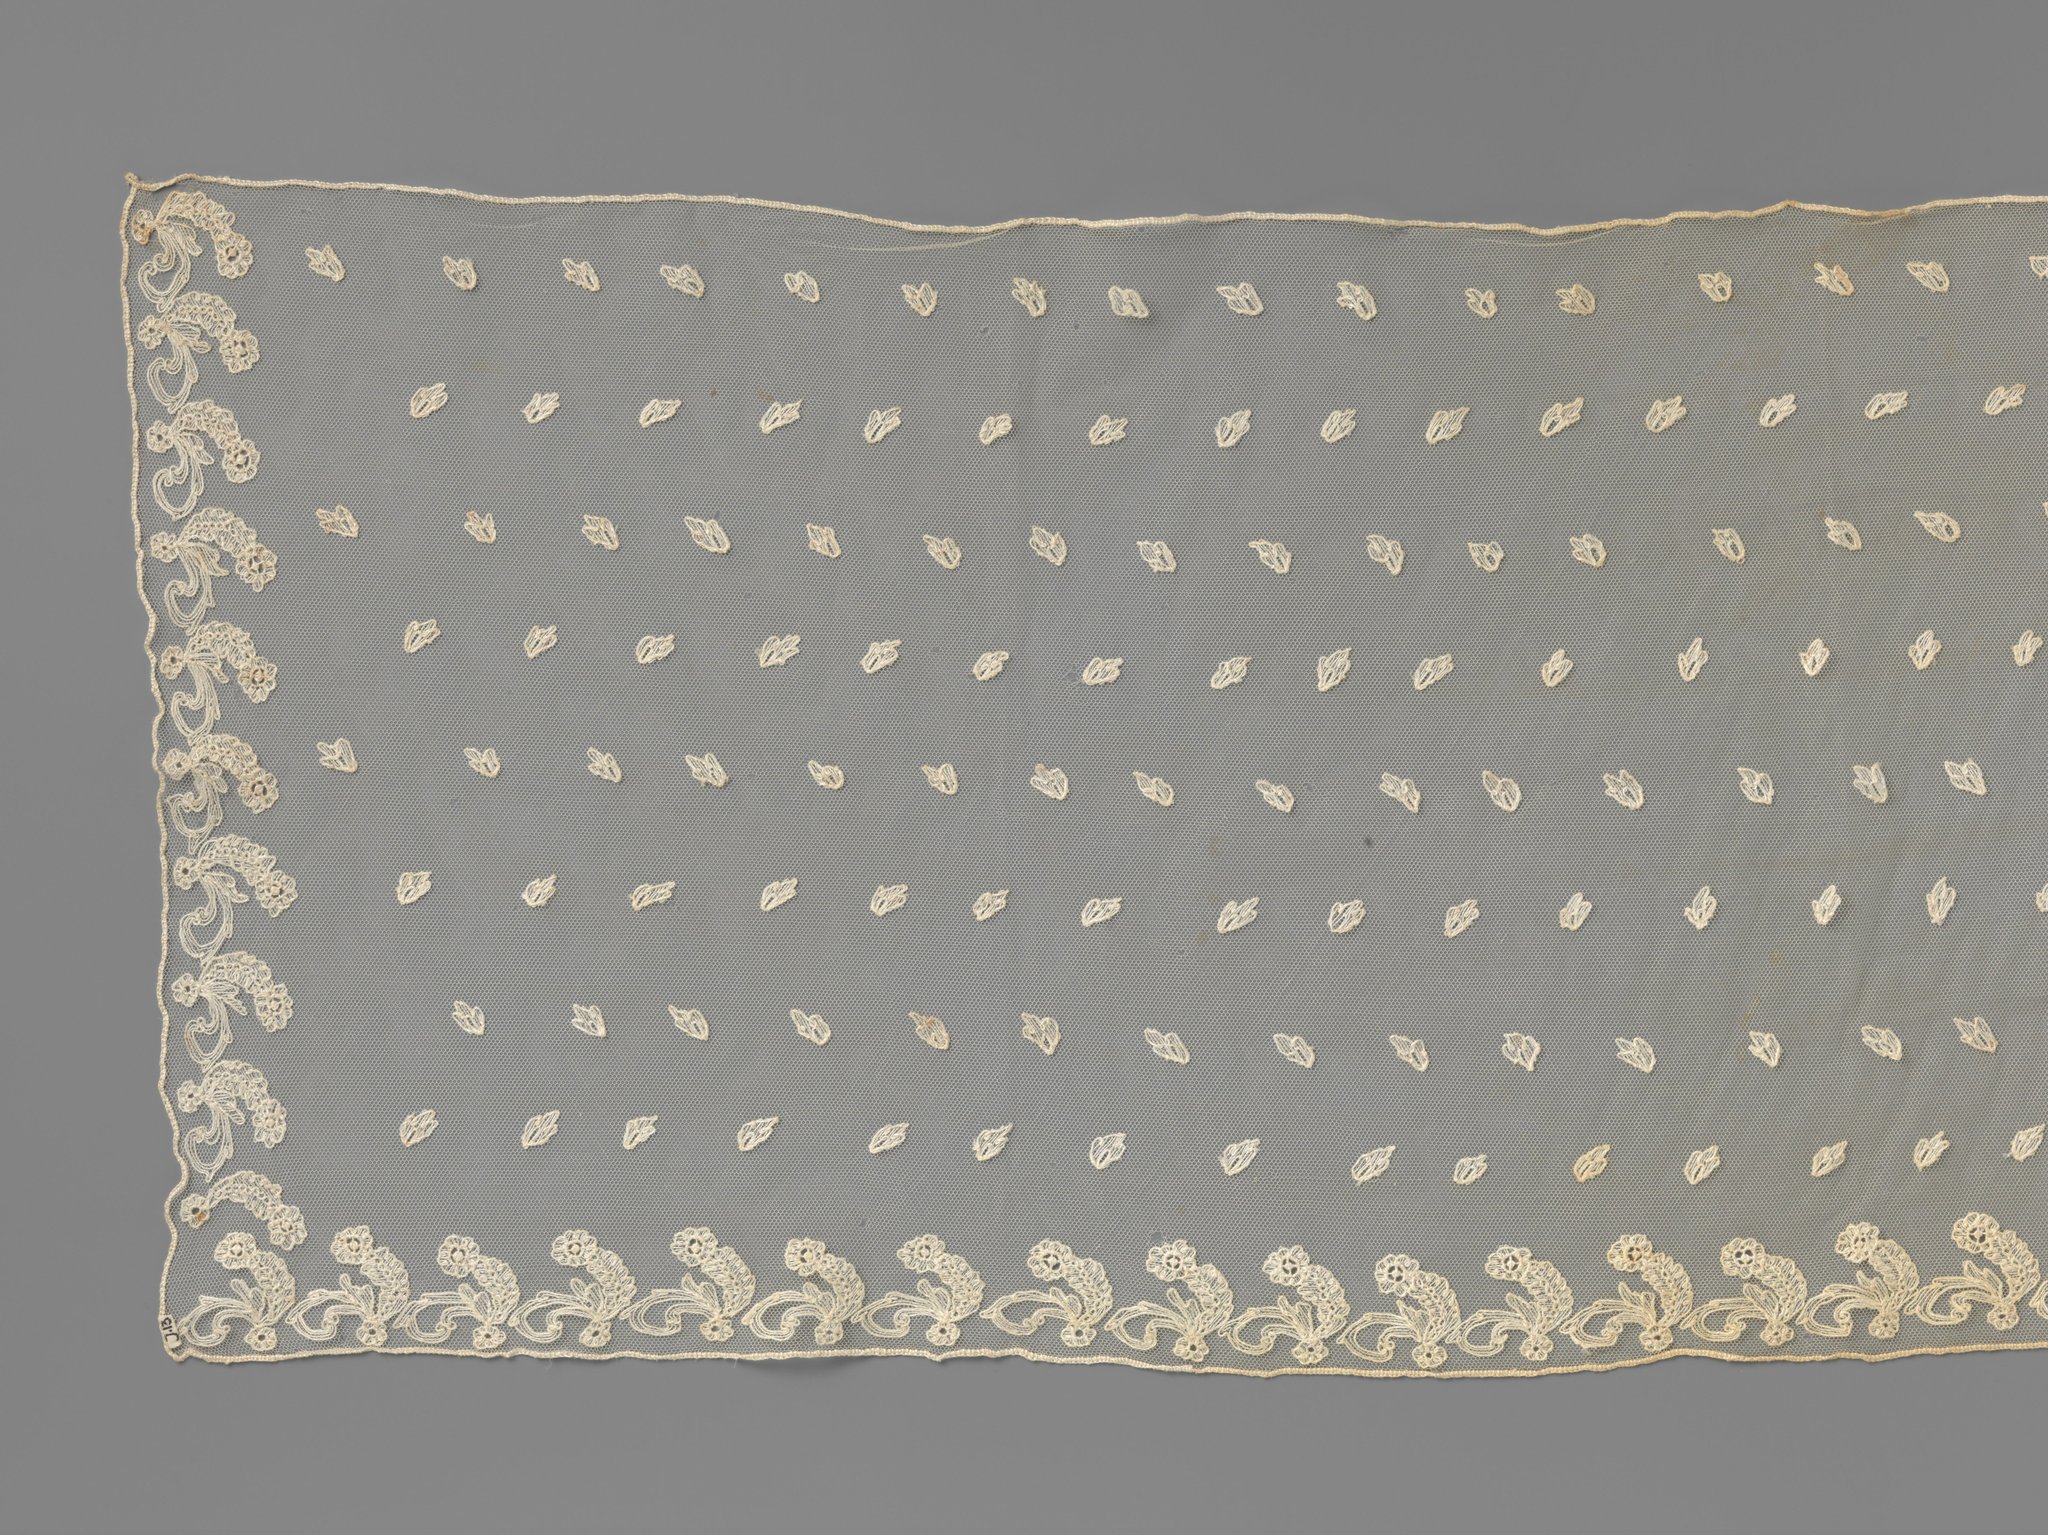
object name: veil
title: Voile van kantborduurwerk op tule met vallende bladeren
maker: Anonymous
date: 1900-1924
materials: linen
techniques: embroidered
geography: belgium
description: Voile van naturelkleurig kantborduurwerk: tuledoorstopwerk op machinale tule. Een rechthoekige tule is met rijtjes vallende bladeren gevuld en aan drie zijden omrand met rozetjes aan dicht bebladerde stelen. Rechte afwerking met festonsteken.